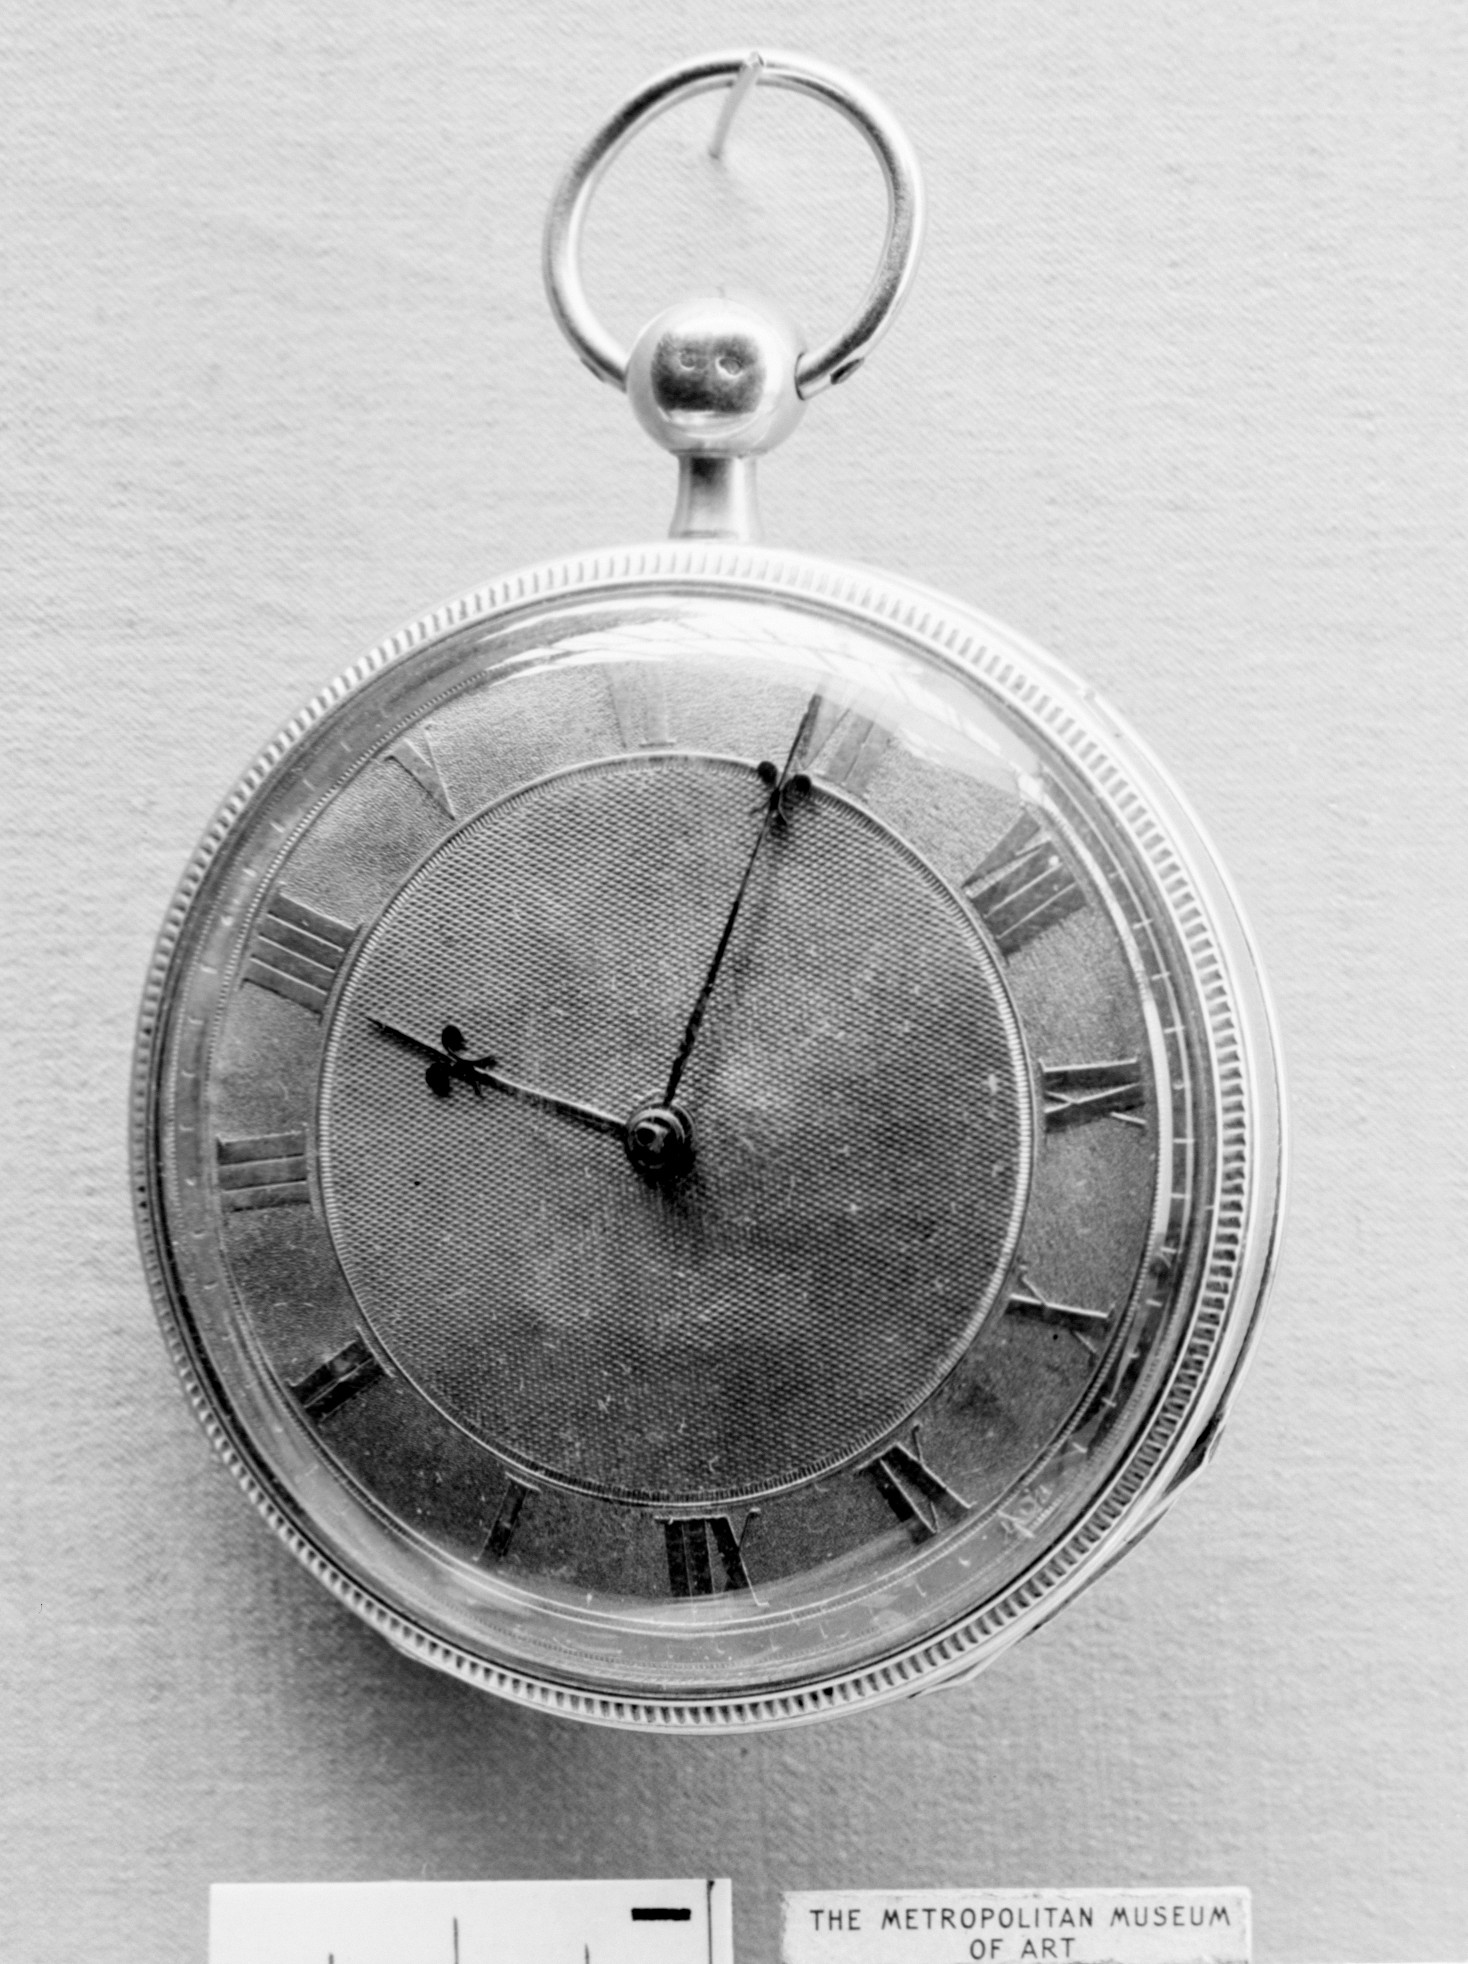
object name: repeating and musical watch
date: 1801-1833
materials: gold